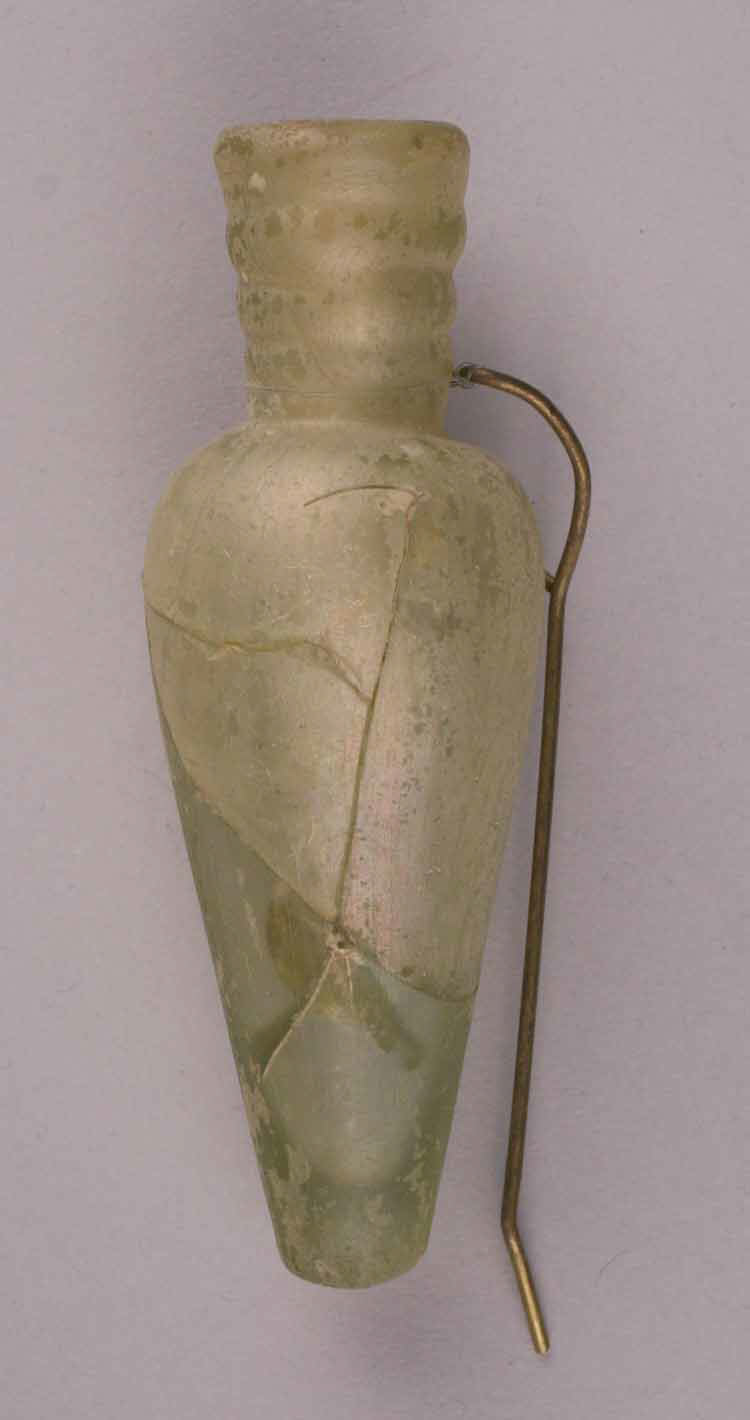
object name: bottle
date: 801-1000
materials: glass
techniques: glassblowing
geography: iran